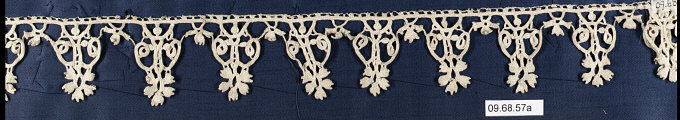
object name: edging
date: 1600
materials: linen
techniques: lace